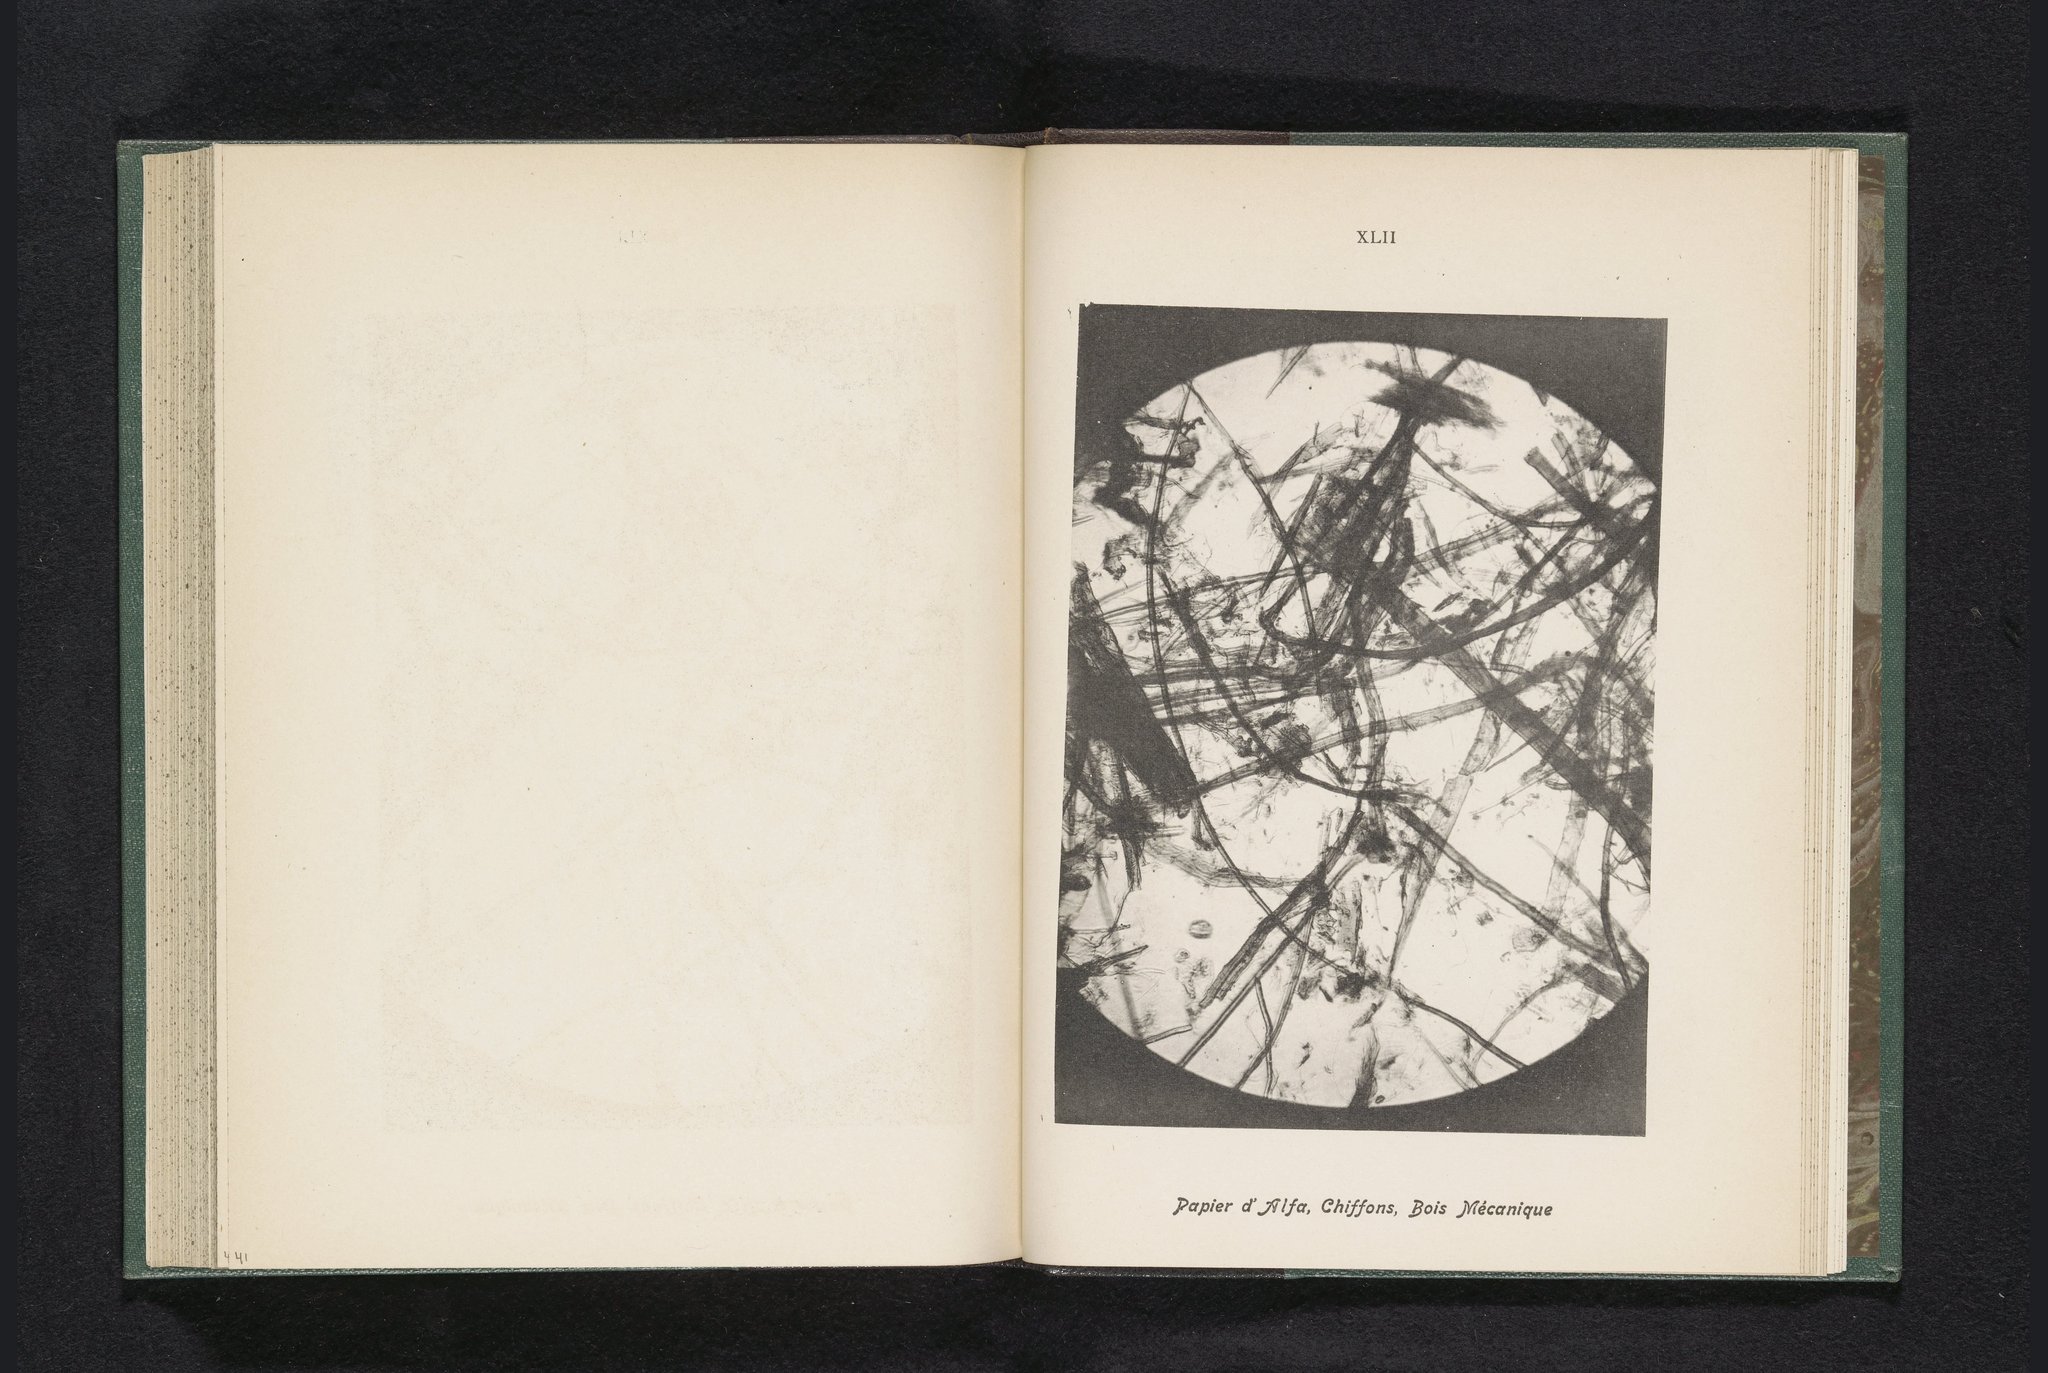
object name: photomechanical print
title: Micro-opname van vezels in papier van espartogras, lompen en hout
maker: Anonymous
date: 1890-1900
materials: paper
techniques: photograph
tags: microscope (+ scientific research)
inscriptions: number: ‘XLII’